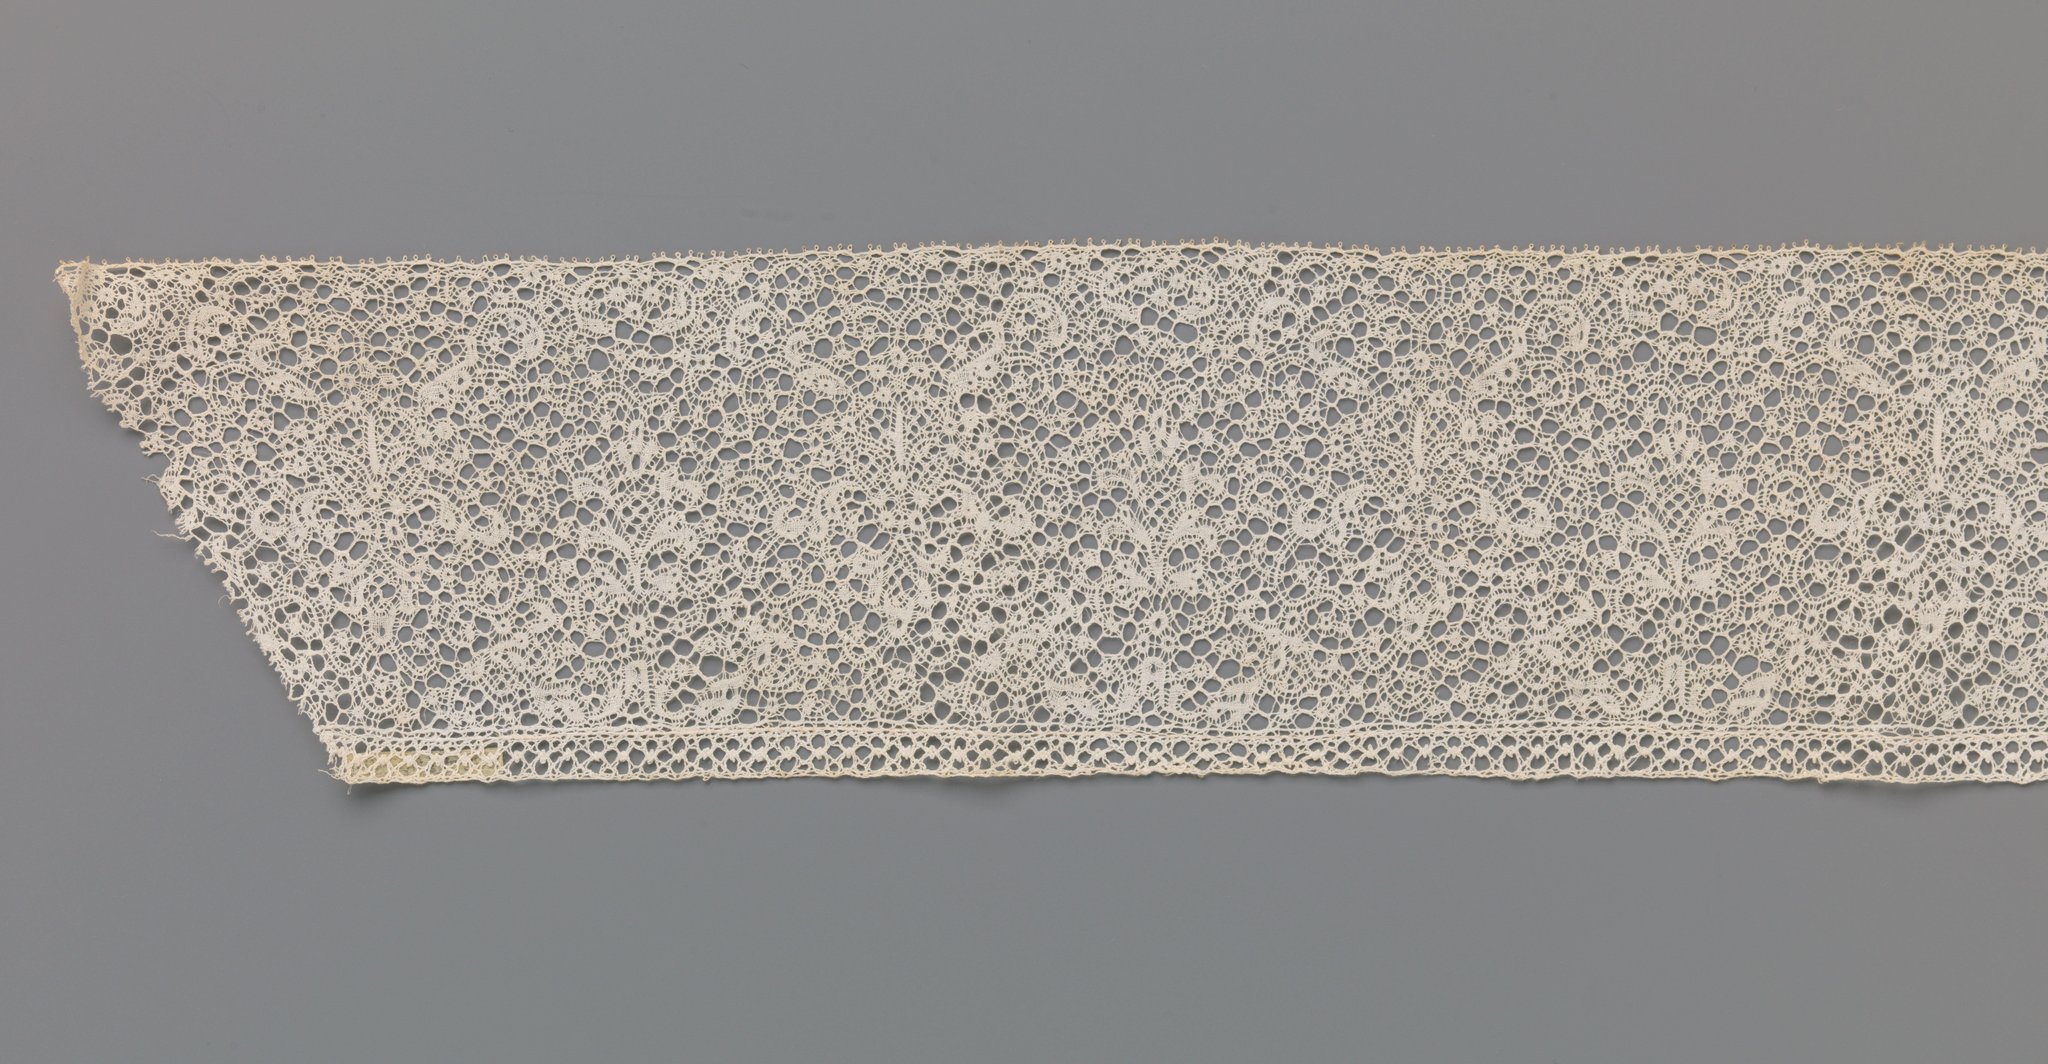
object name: strip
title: Strook kloskant met twee kandelabermotieven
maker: Anonymous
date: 1690-1699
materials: linen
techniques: lace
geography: southern netherlands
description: Strook naturelkleurige kloskant, Binche-kant. Het zich herhalende en ijle patroon bestaat uit een twee verschillende symmetrische kandelabermotieven. De smalste van de twee heeft een druppelvormig centrum, de bredere is vanuit vier punten rond het centrum voorzien van voluutjes, en vormen een x. De kandelabermotieven staan afwisselend omgekeerd. De motieven zijn met elkaar verbonden door een onregelmatige siergrond, een sneeuwvlokkengrond. De bovenzijde is afgewerkt met een apart geklost bandje. De onderzijde is recht afgewerkt en voorzien van picots.